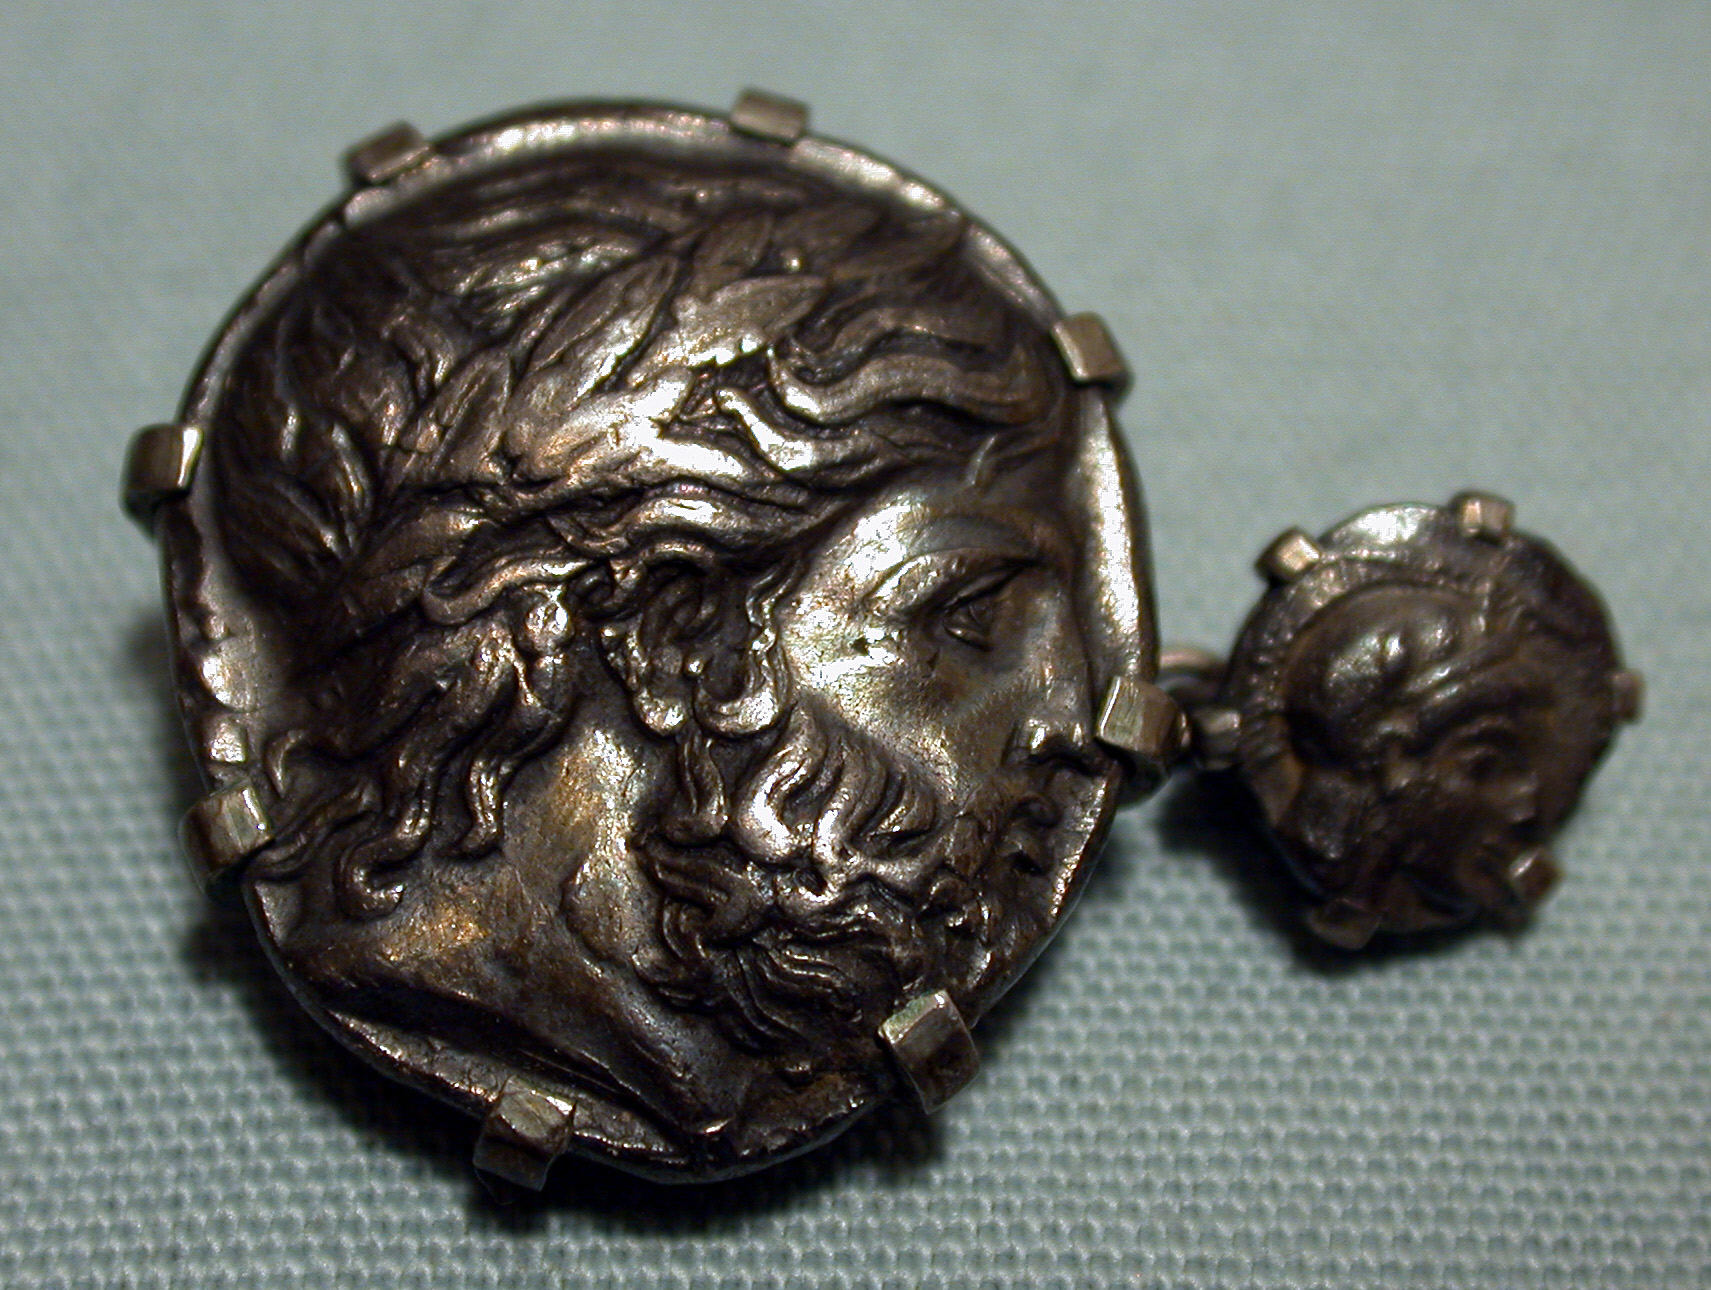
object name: tetradrachm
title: Silver tetradrachm of Philip II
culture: greek, macedon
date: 359-355 BCE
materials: silver